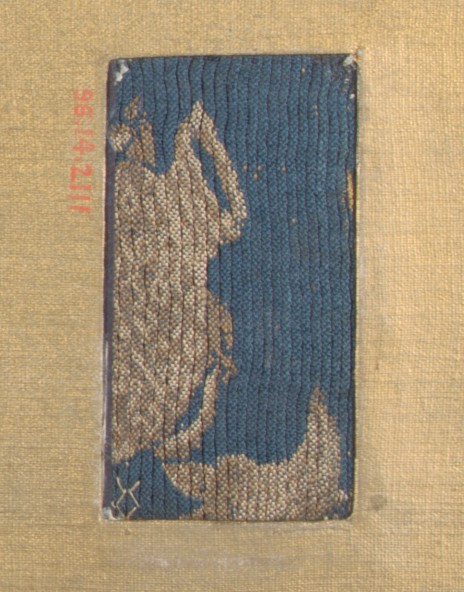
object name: piece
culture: japanese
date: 1701-1900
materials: silk